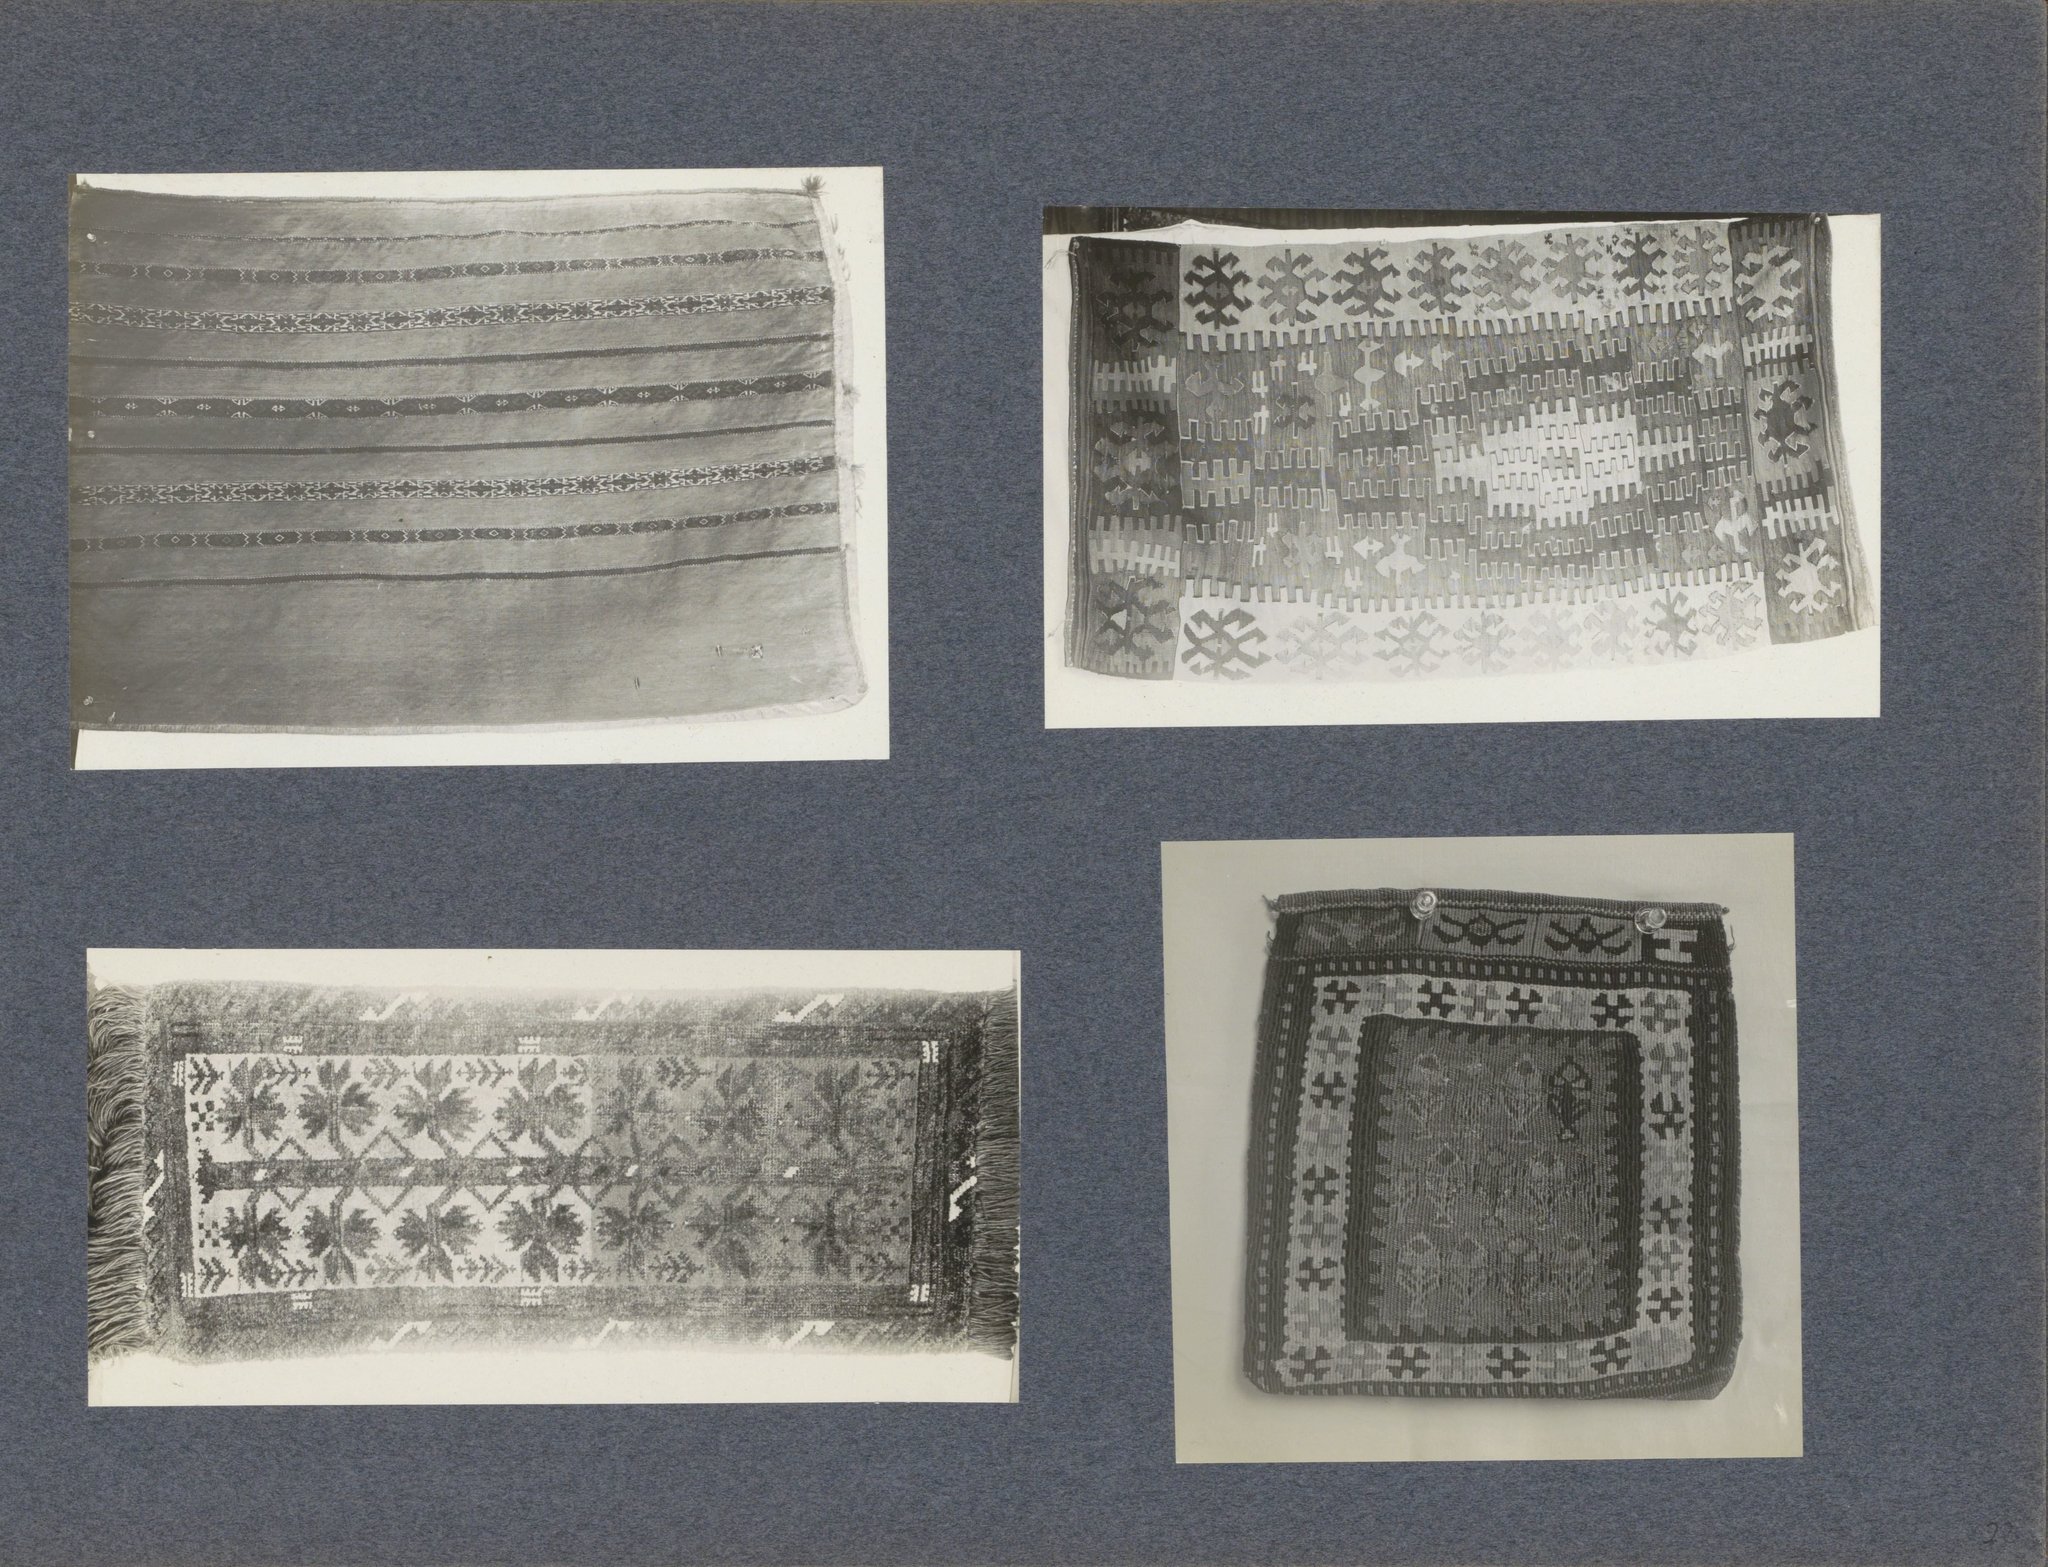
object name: album leaf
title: Tapijten (2)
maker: Anonymous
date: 1910-1911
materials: cardboard, paper, photographic support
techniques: gelatin silver print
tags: carpet, rug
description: Albumblad met vier foto's van tapijten. Onderdeel van Fotoalbum van de familie Palthe uit Almelo.